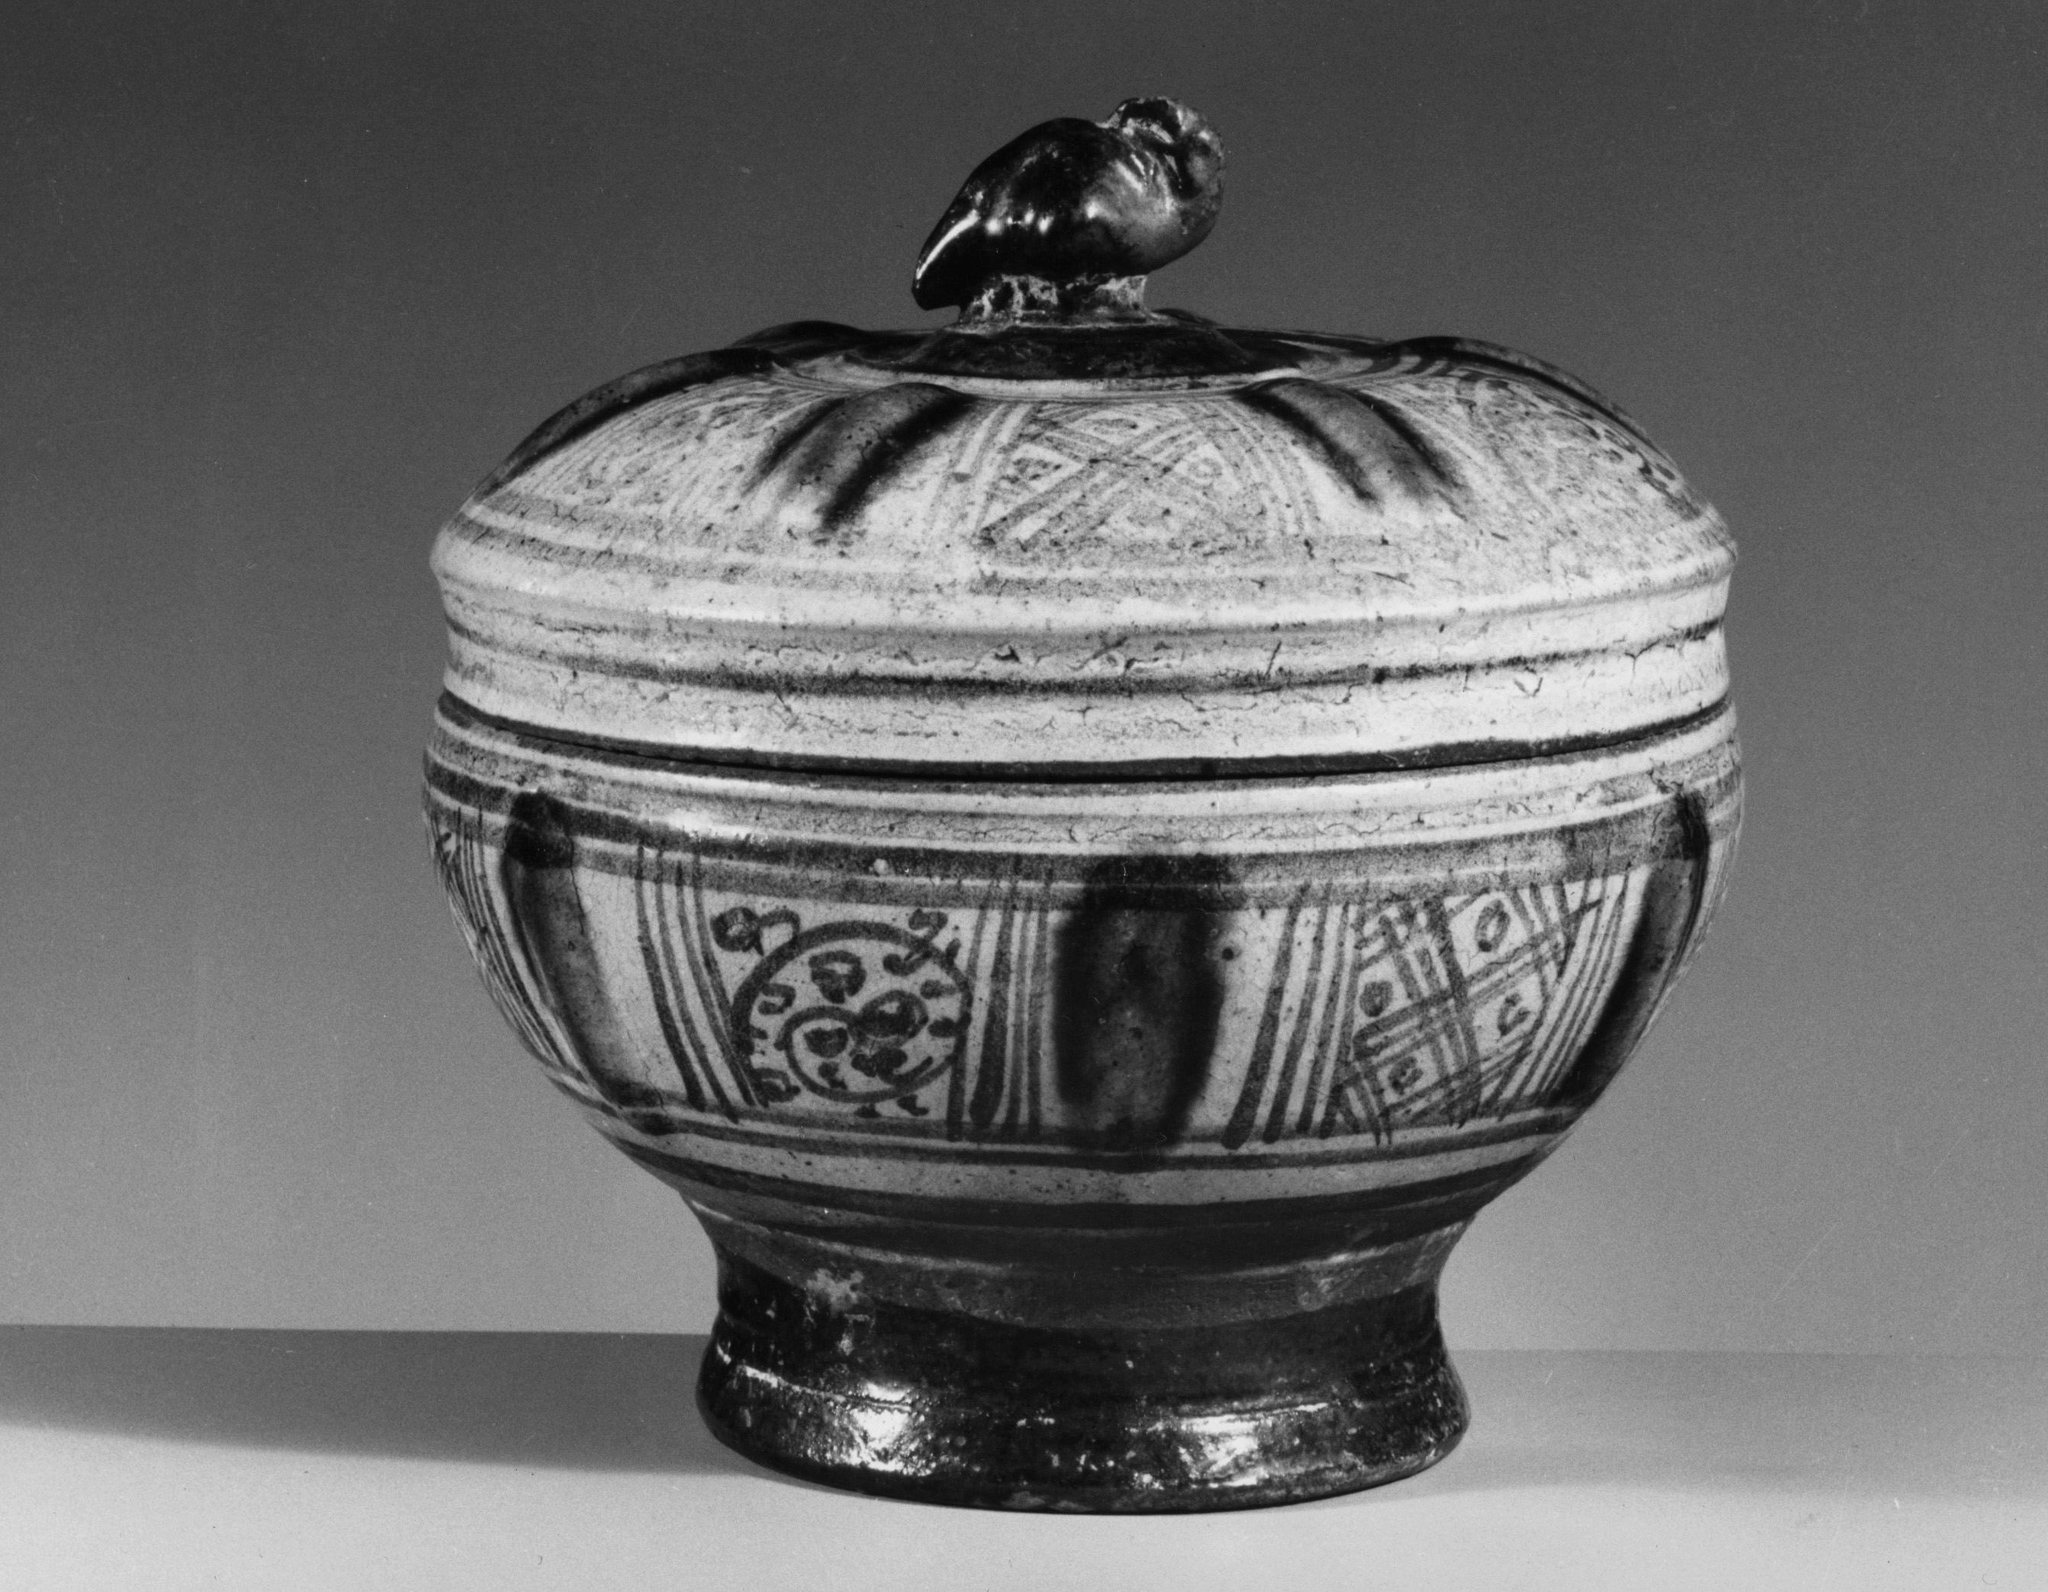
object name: vessel with lid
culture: thai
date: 1401-1500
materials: earthenware